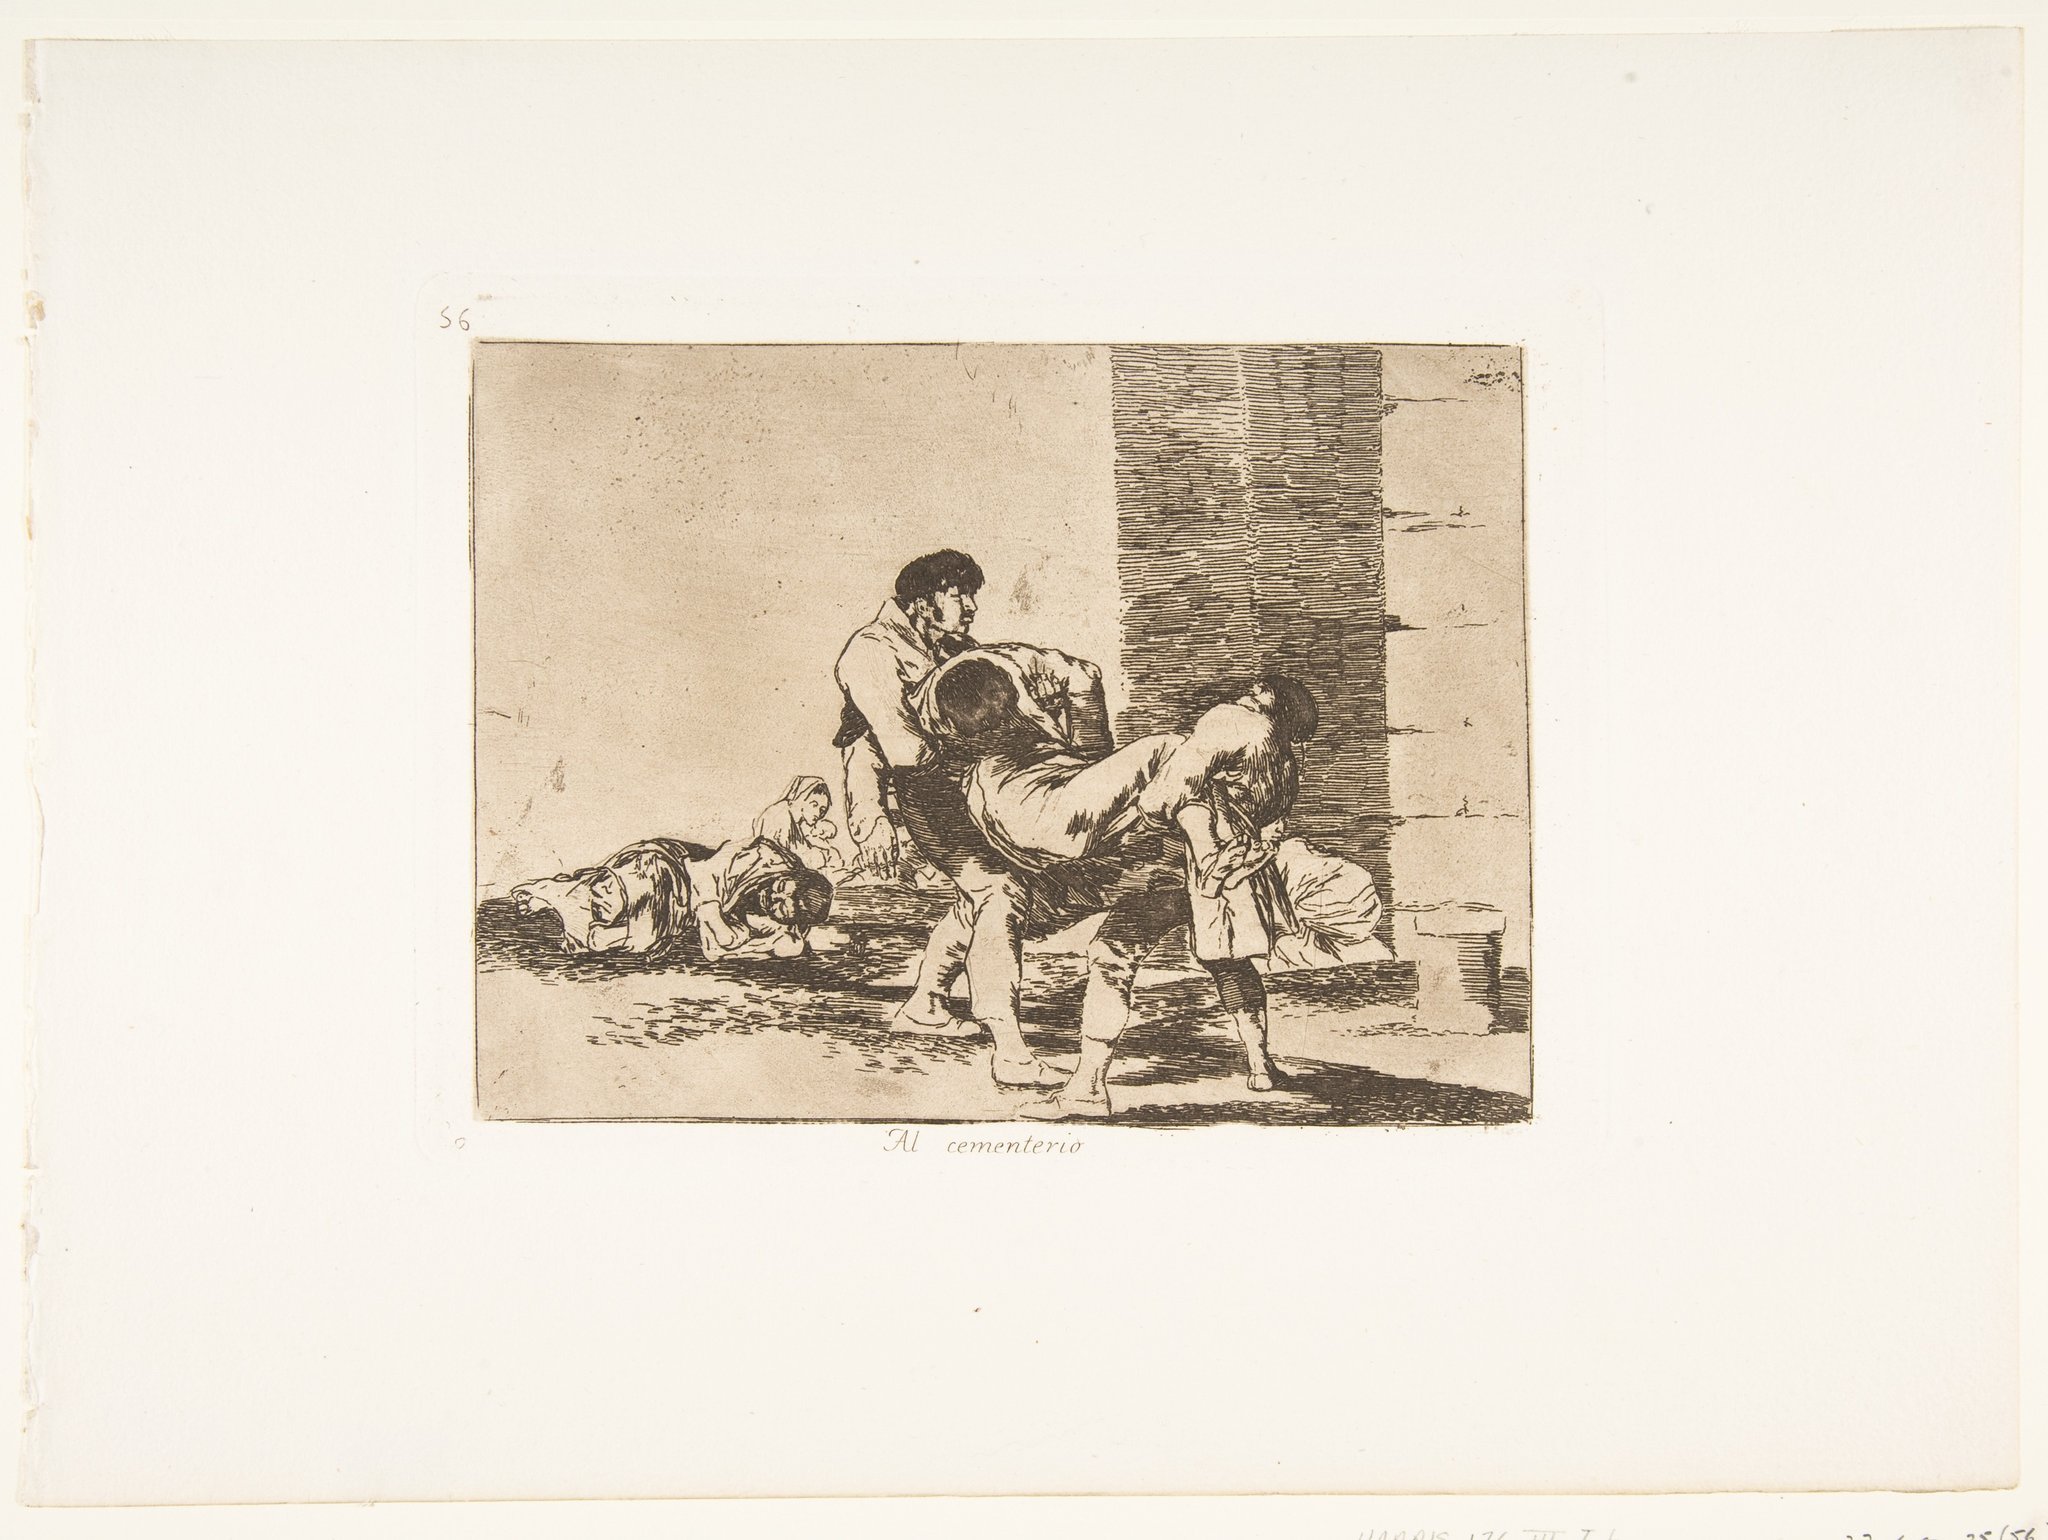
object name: print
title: Plate 56 from "The Disasters of War" (Los Desastres de la Guerra): 'To the cemetery' (Al cementerio)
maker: goya (francisco de goya y lucientes)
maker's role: artist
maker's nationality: spanish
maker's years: 1746-1828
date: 1811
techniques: drypoint, etching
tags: corpses,men